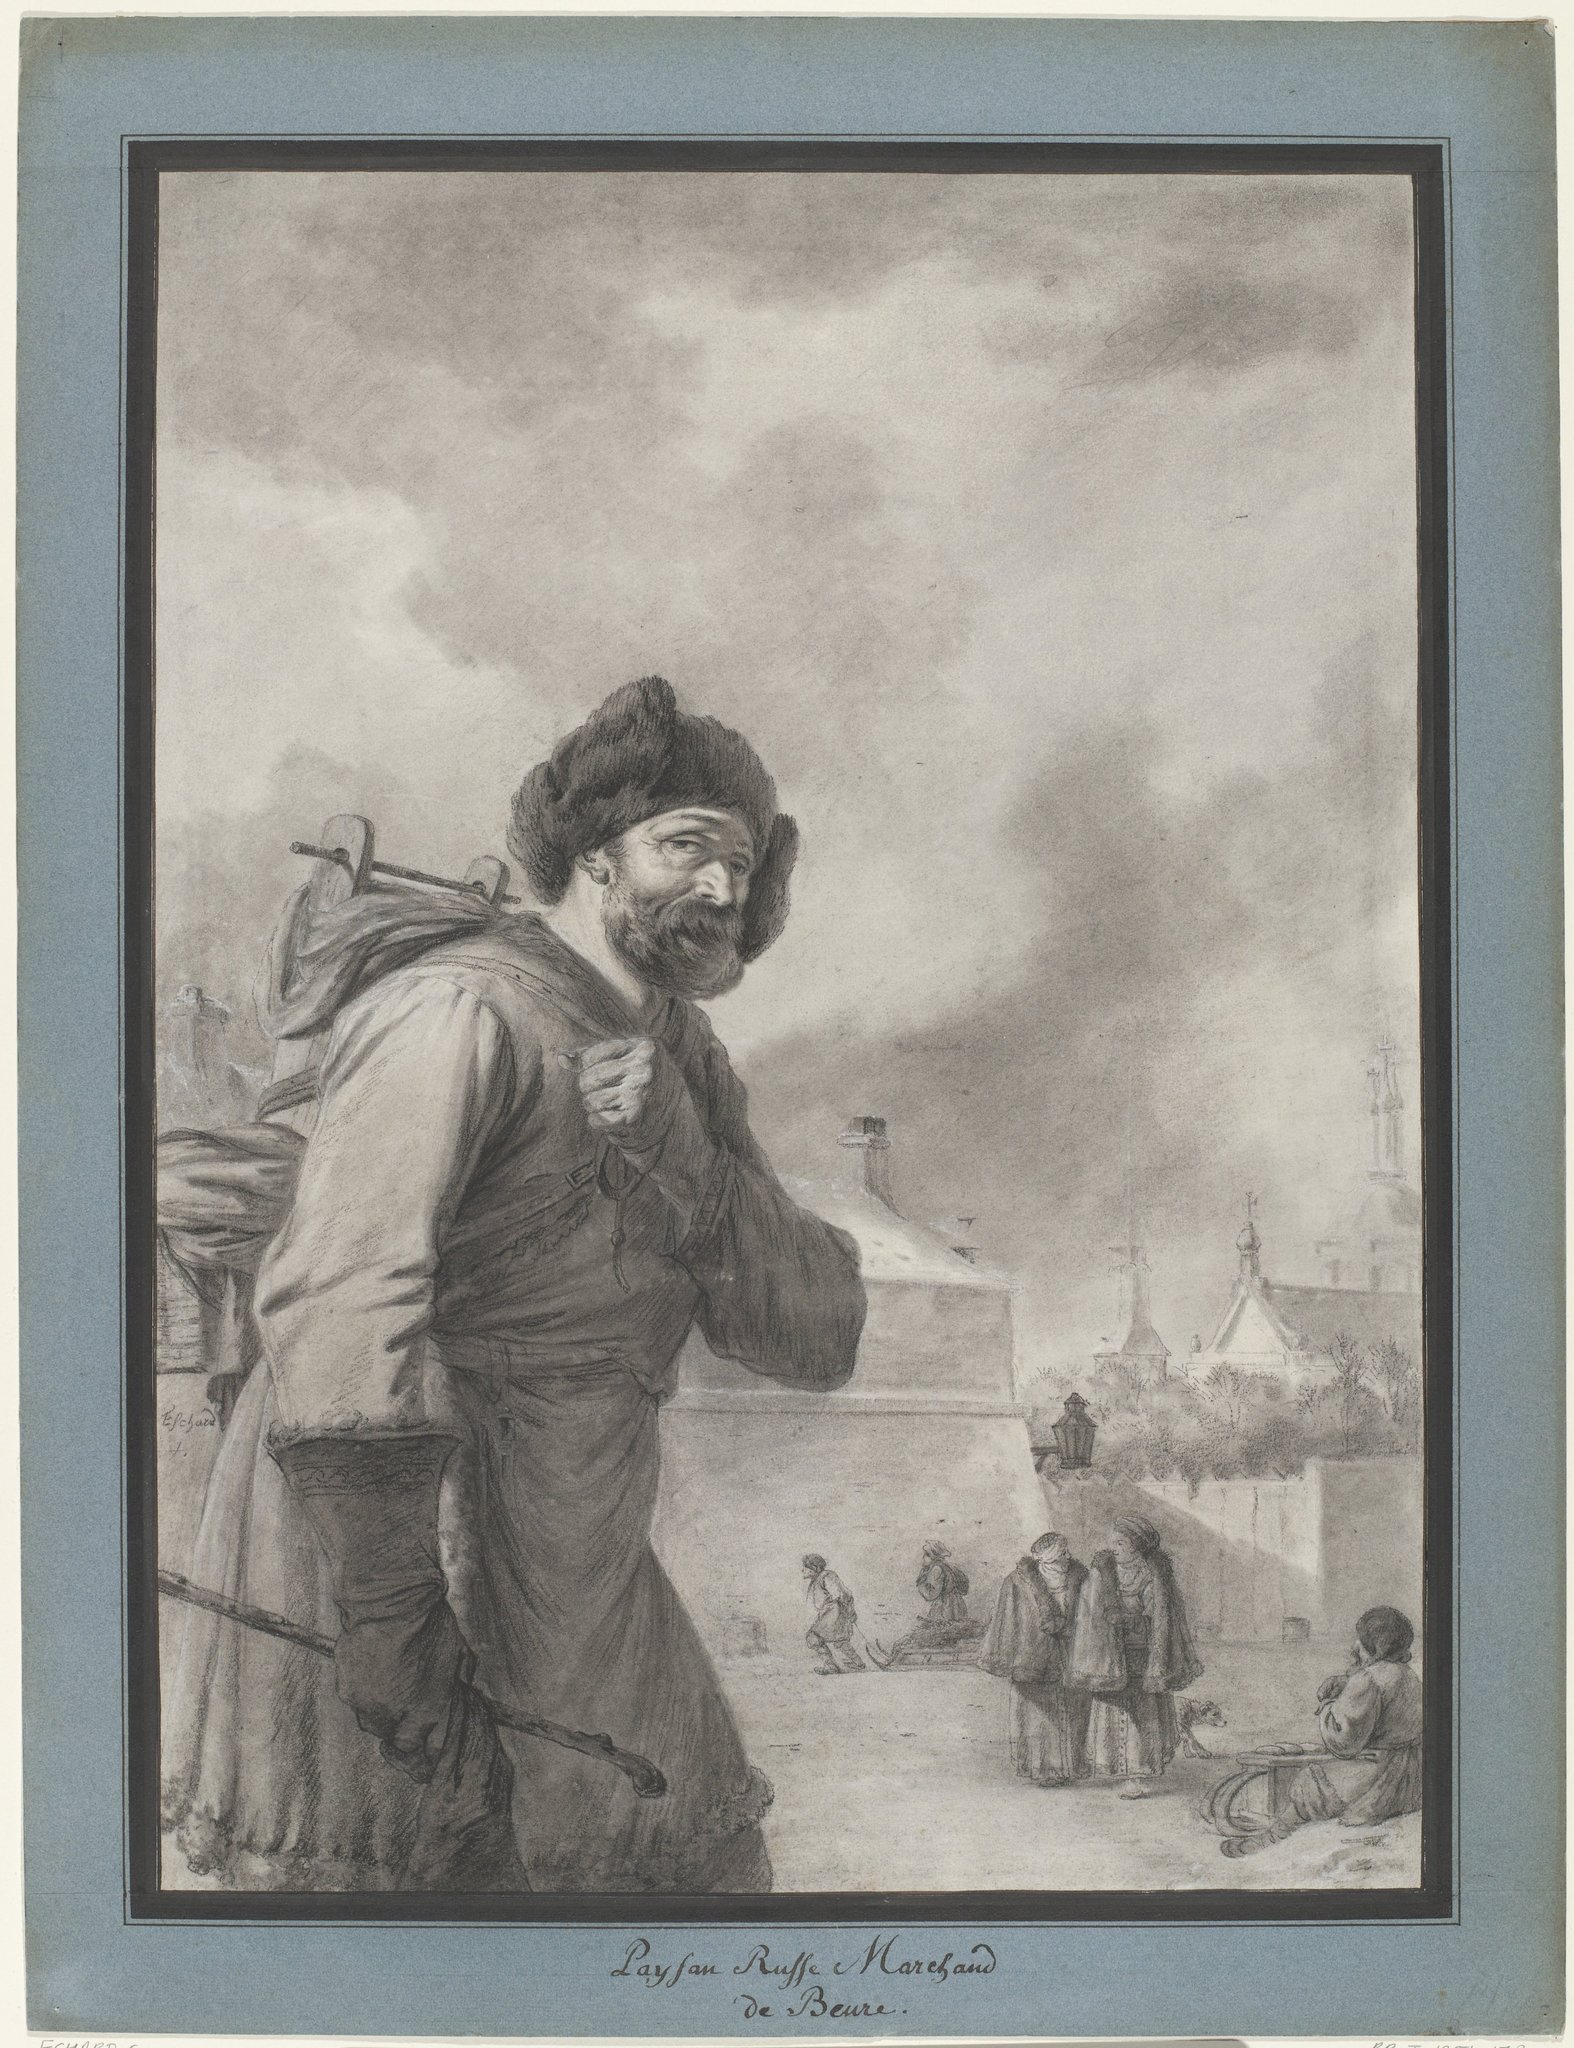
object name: drawing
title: Russische boer met vaatje op de rug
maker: charles echard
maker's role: draughtsman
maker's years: 1748-1810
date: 1758-1810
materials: chalk, paper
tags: farmers, europeans (with name)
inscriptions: annotation, on the old mount, lower centre, pen and black ink: ‘Paysan Russe Marchand / de Beure’, signature, recto, along the left edge, black chalk: ‘Eschard / f.’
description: Russische boer met vaatje op de rug; op de achtergrond een stadsgezicht bij winter, met figuren en sleden.